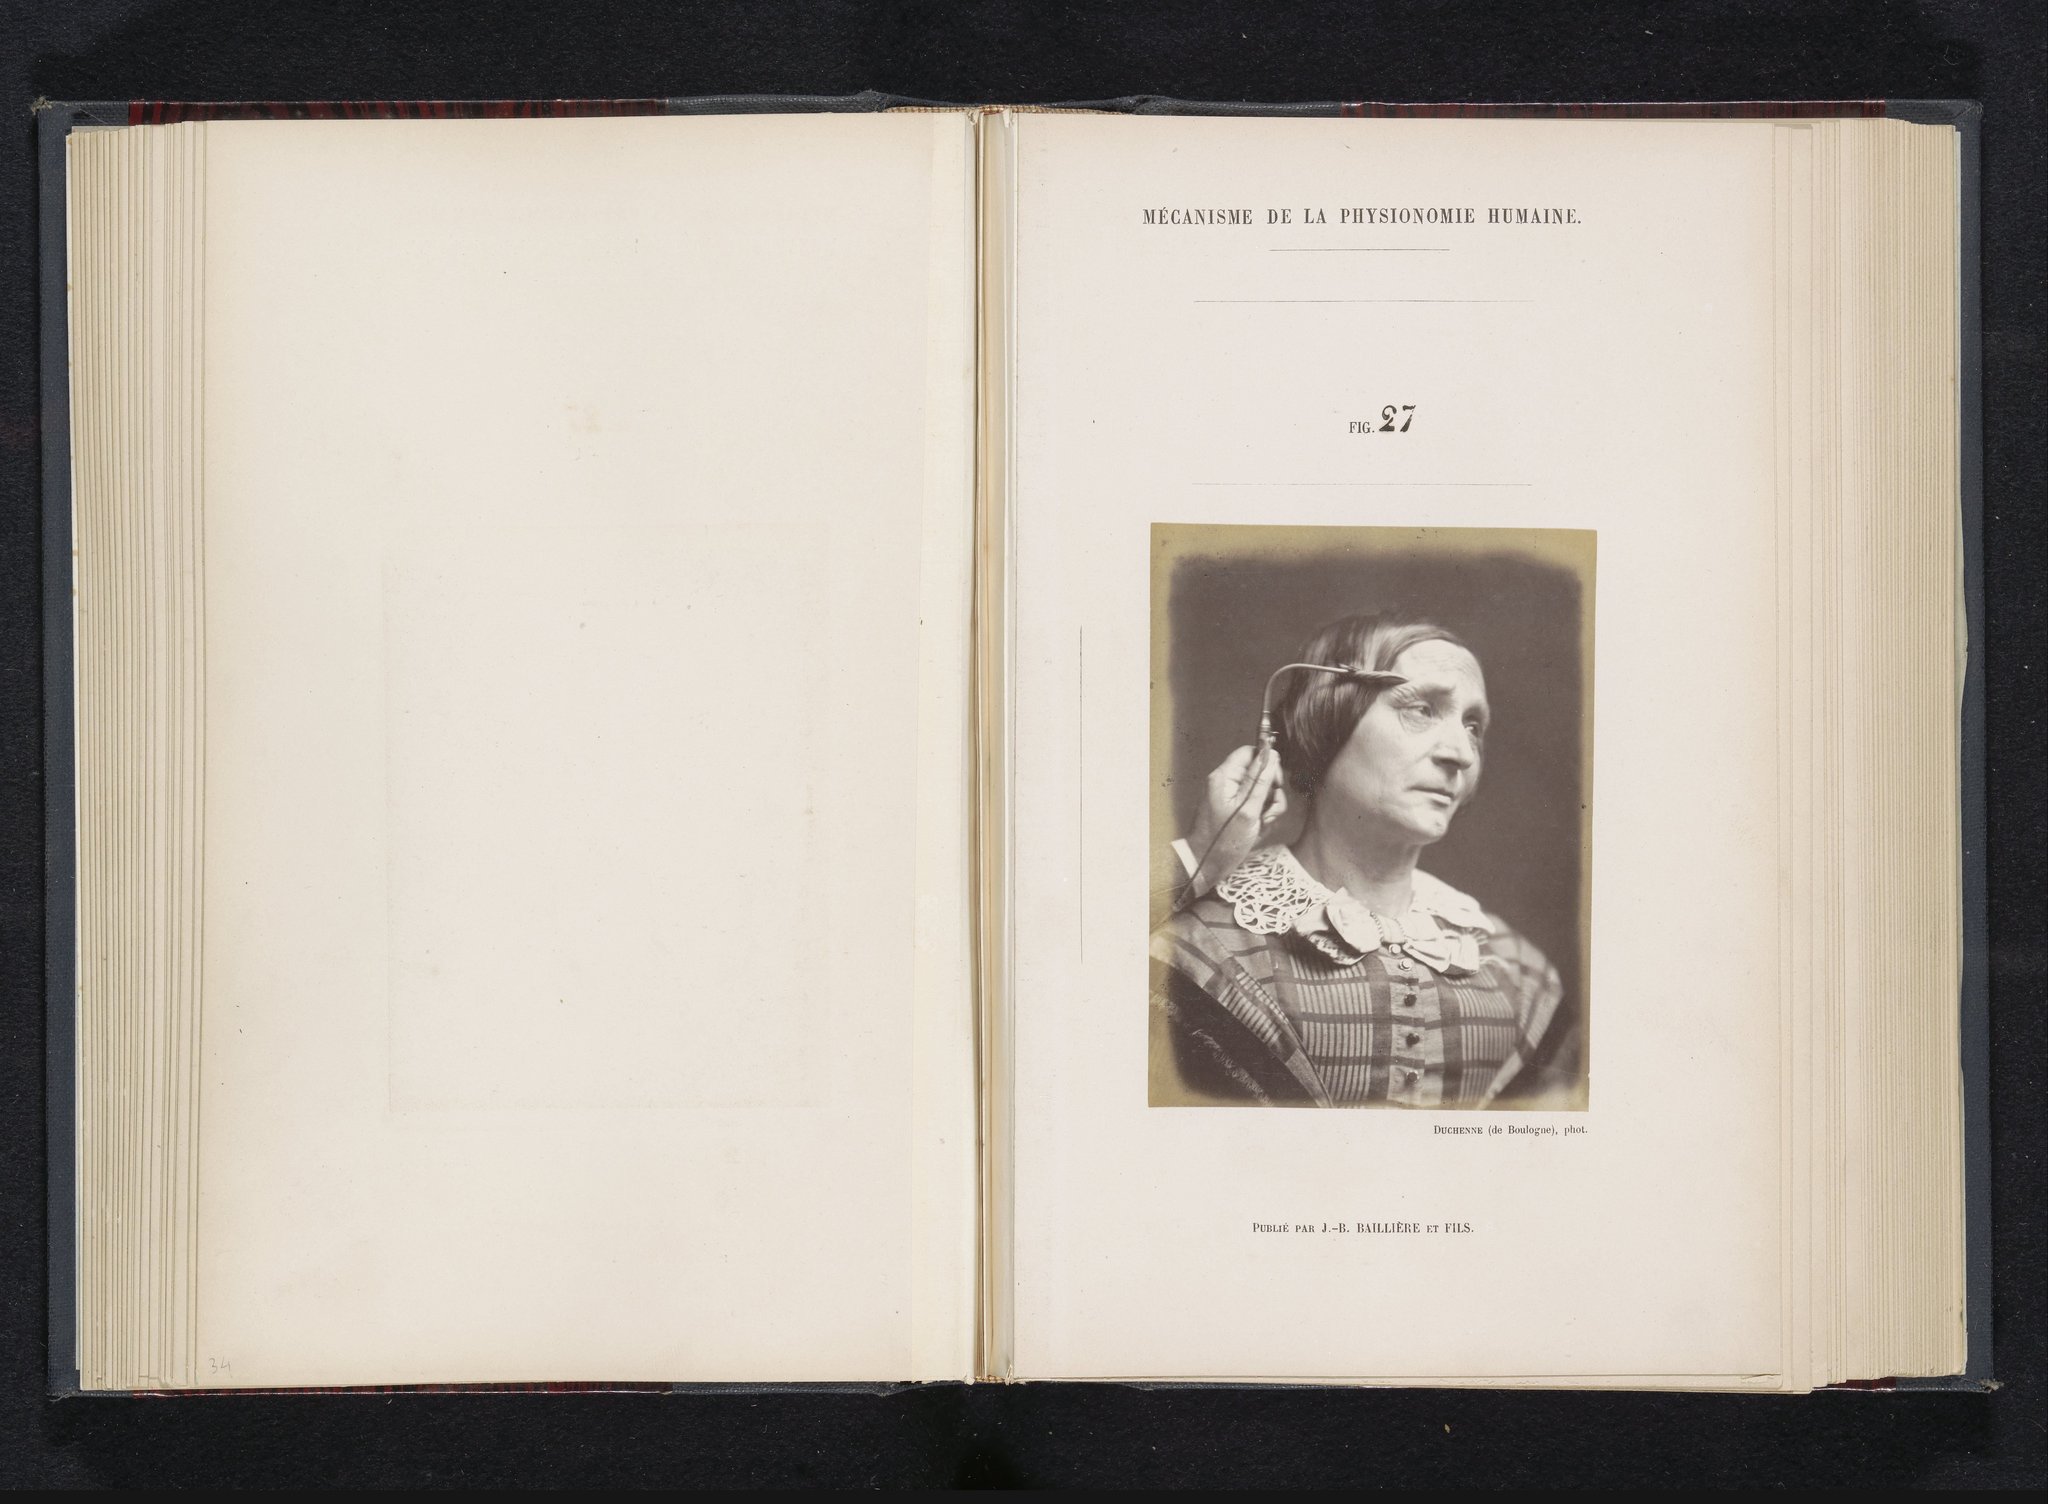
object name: page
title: Portret van een proefpersoon tijdens elektrostimulatie: 'une femme âgée de cinquante-deux'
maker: guillaume benjamin amand duchenne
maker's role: fotograaf, medicus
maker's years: 1806-1875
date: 1860-1862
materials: paper, photographic support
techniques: albumen print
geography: france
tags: face, adult woman, physiology and anatomy ~ nervous system, neurology, physiology and anatomy, morphology of facial expression, physiognomy, experiment, test ~ science and technology, france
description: Ongenummerde pagina met foto 27 uit Mécanisme de la physionomie humaine ou analyse électro-physiologique de l'expression des passions (Atlas).